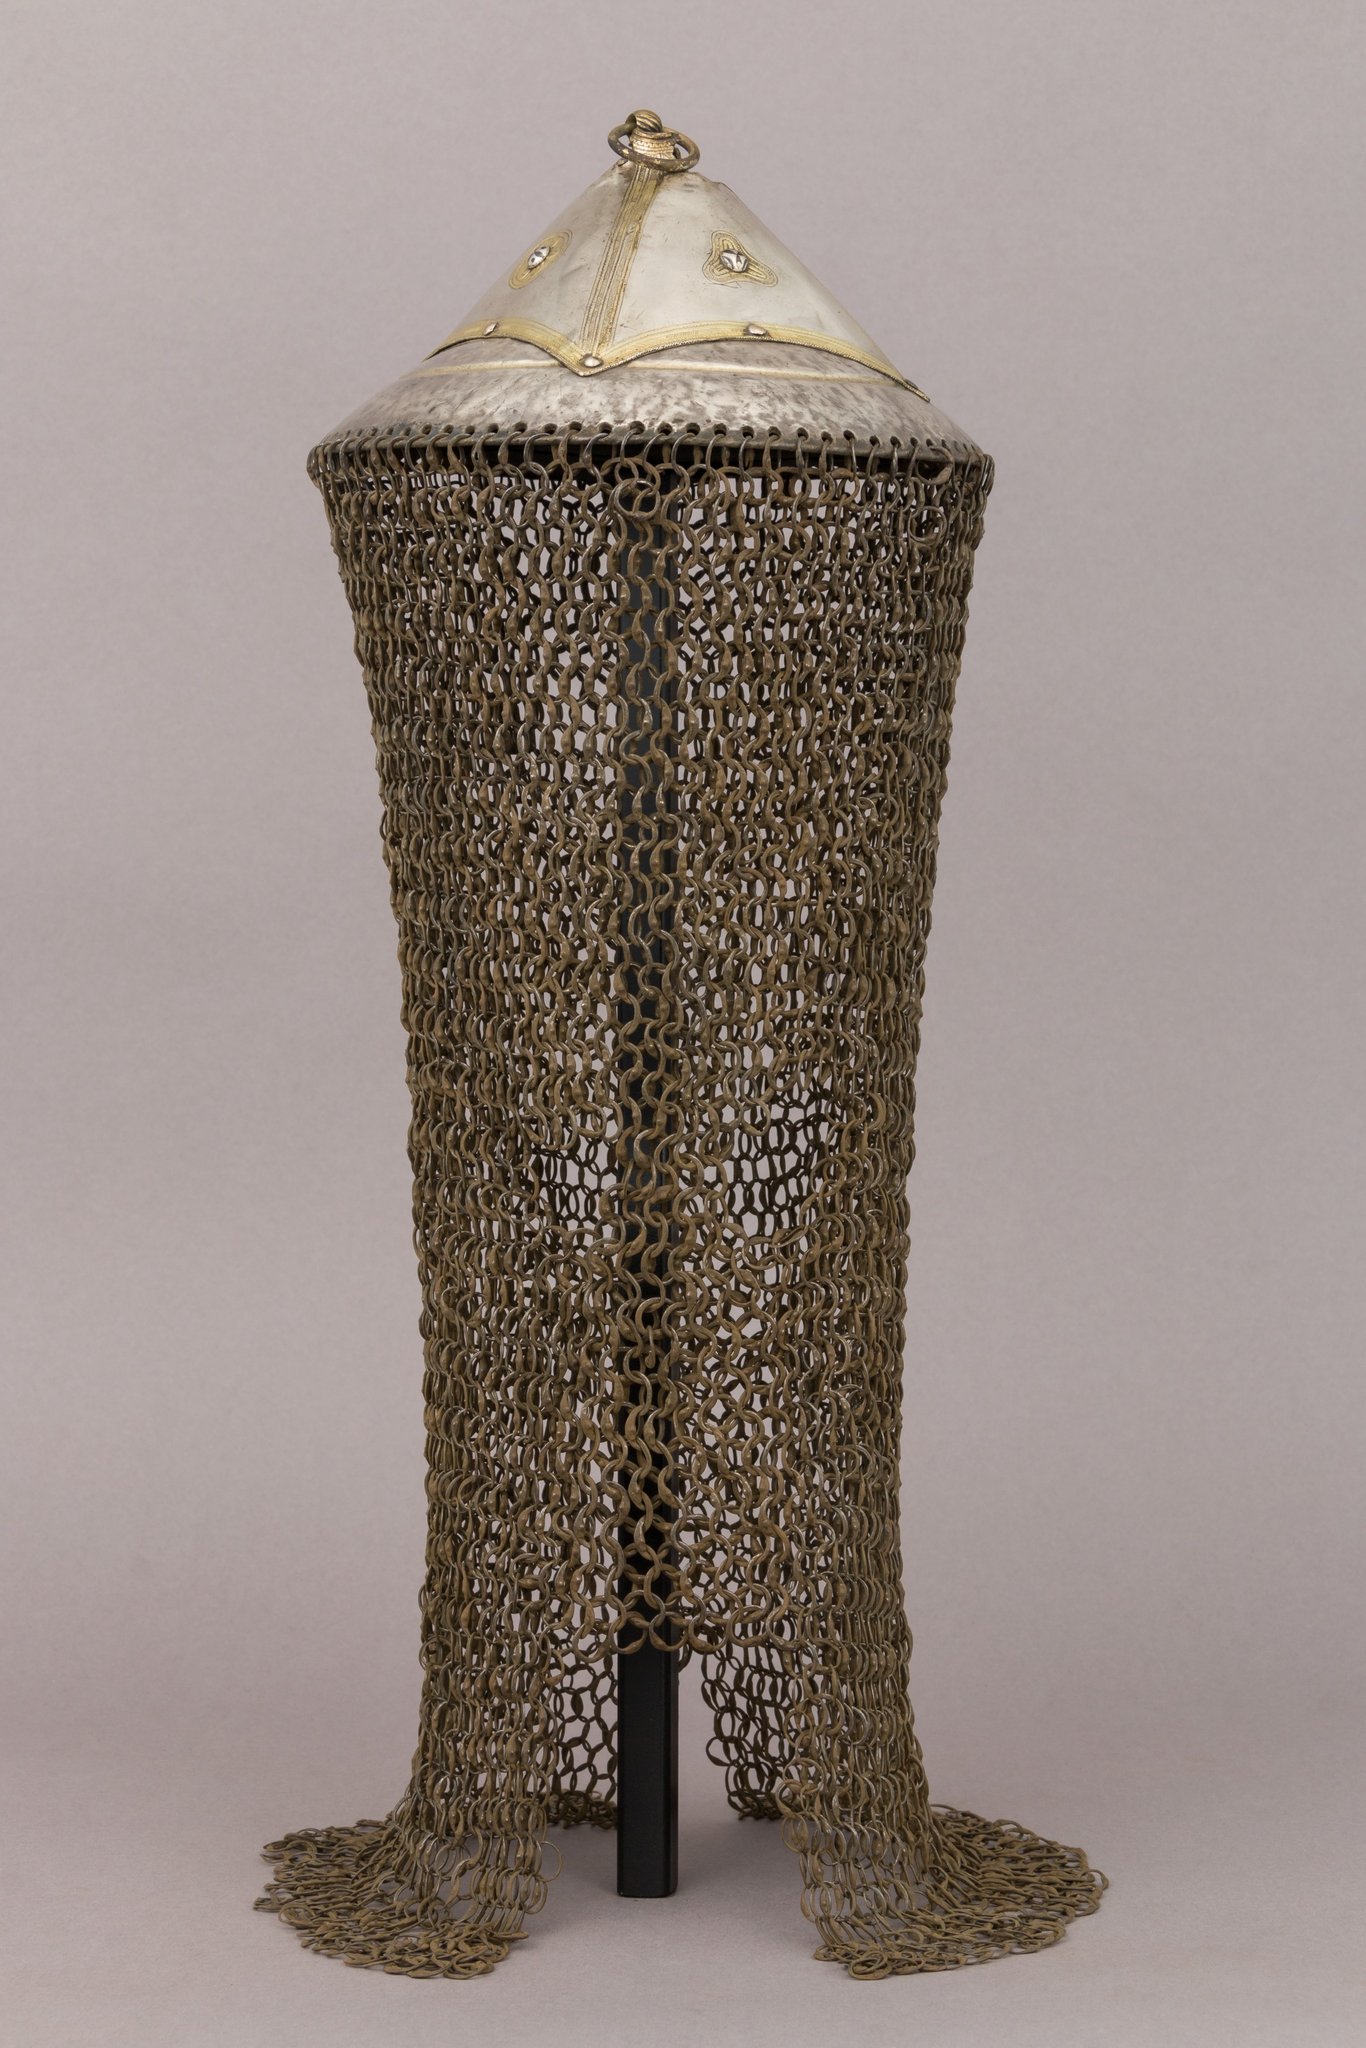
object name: helmet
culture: caucasian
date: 1701-1900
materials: copper alloy, silver, steel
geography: caucasus